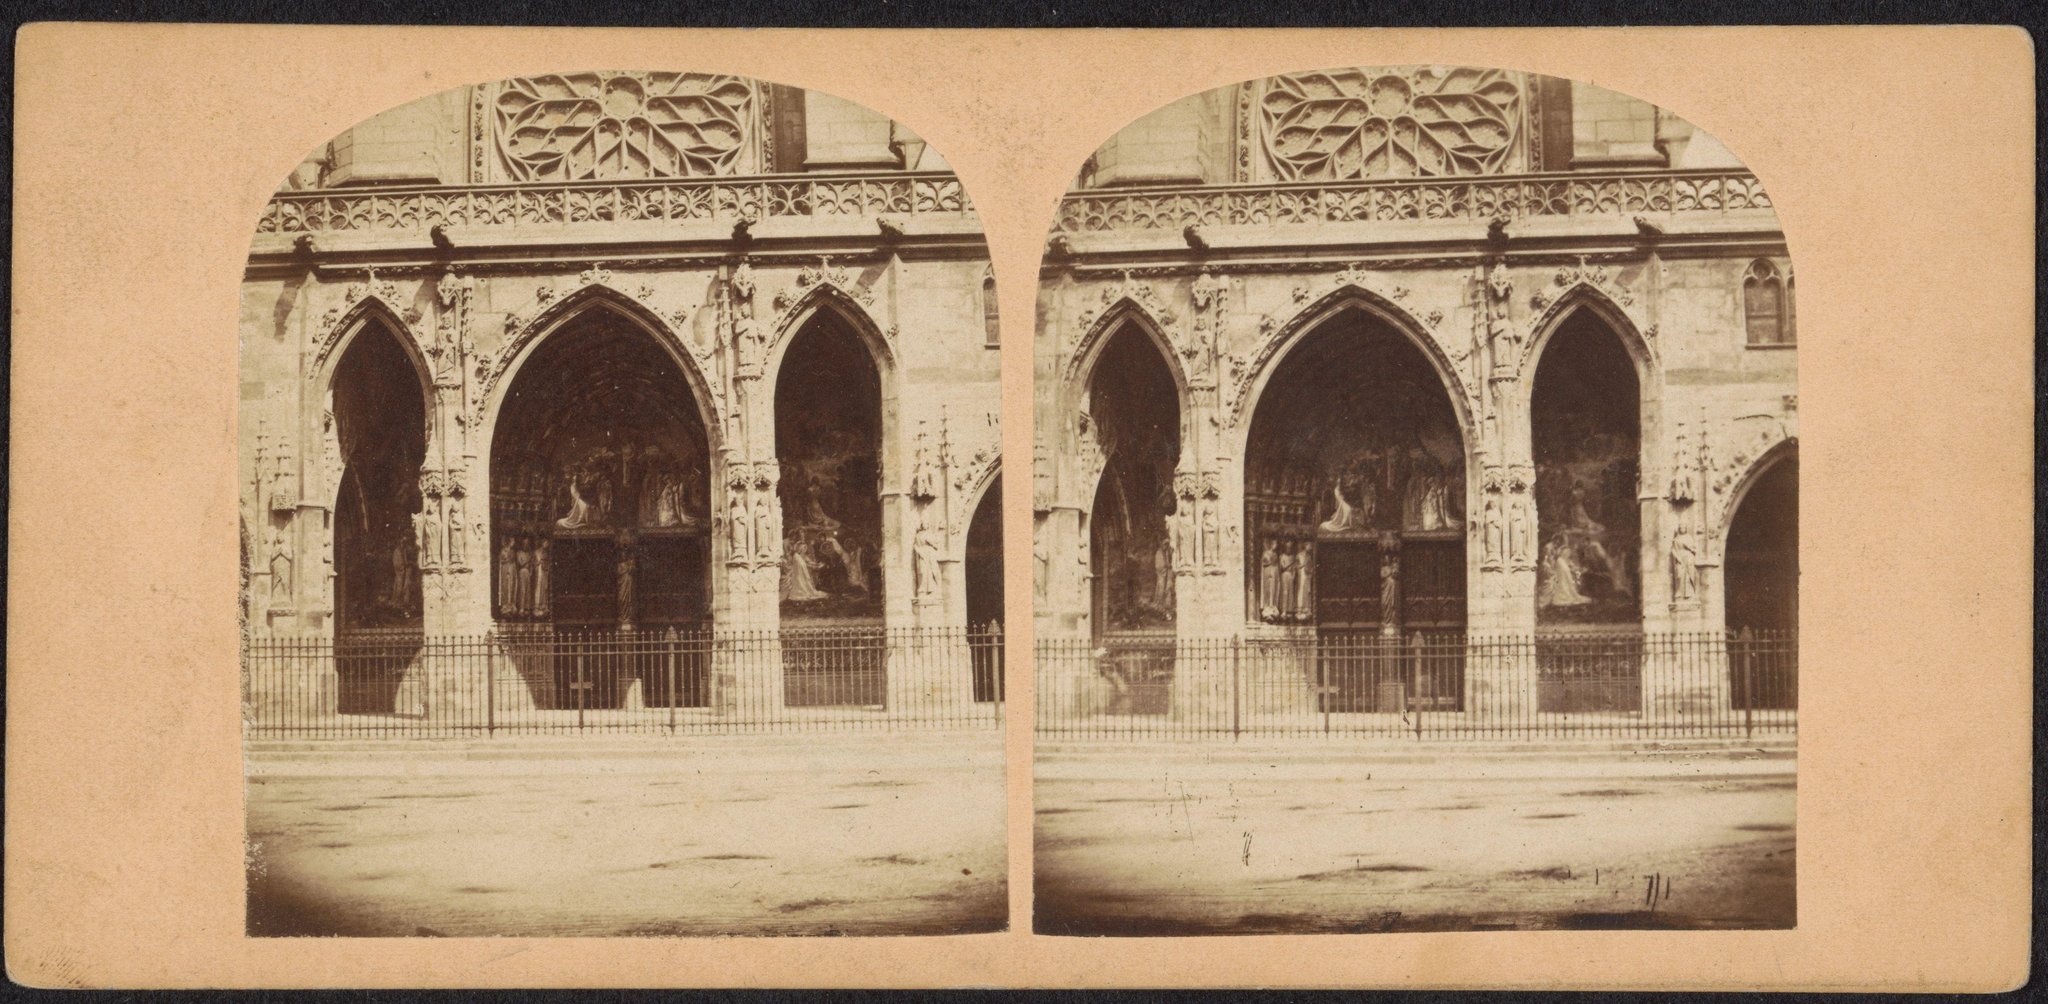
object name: stereograph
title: Gezicht op een portaal van de Notre-Dame in Parijs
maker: Anonymous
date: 1855-1860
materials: cardboard, photographic support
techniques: albumen print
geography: paris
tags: parts of church exterior and annexes: portal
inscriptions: inscription: ‘Portail, Notre Dame’, number: ‘64’